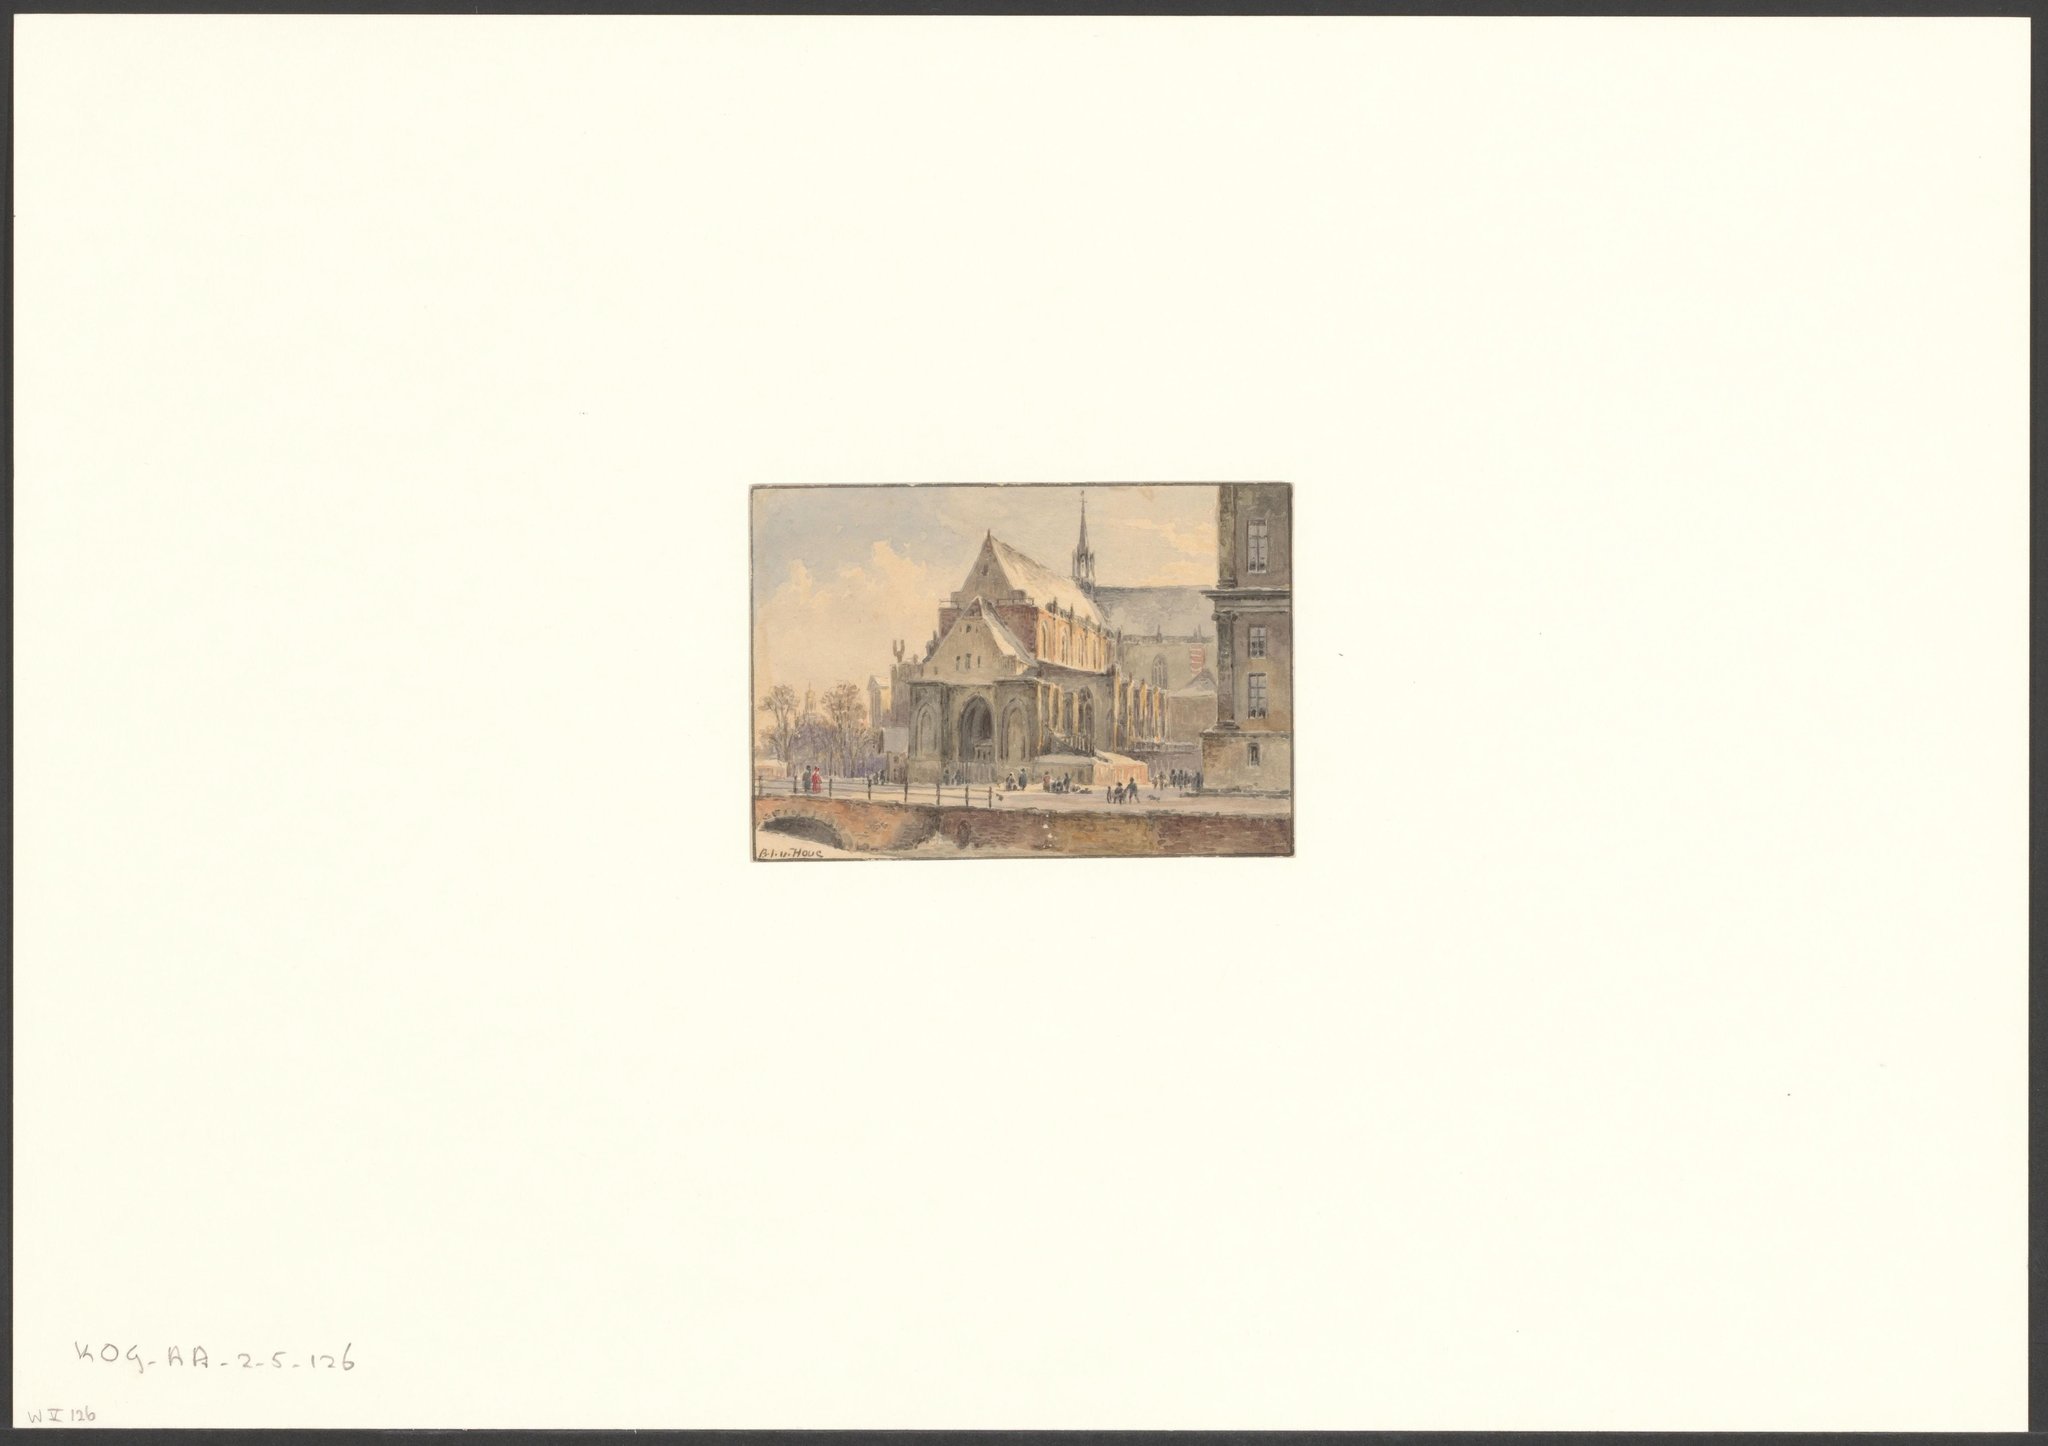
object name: drawing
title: Gezicht op de Nieuwe Kerk op de Dam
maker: bartholomeus johannes van hove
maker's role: draughtsman, painter, print maker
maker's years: 1790-1880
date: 1800-1880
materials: paper, pencil, watercolor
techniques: brush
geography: amsterdam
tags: parts of church exterior and annexes: façade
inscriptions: signature: ‘B.J.v.Hove’, collector's mark: Lugt 800a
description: Tekening binnen de Atlas Van Eck ingedeeld op wijknummer 5.